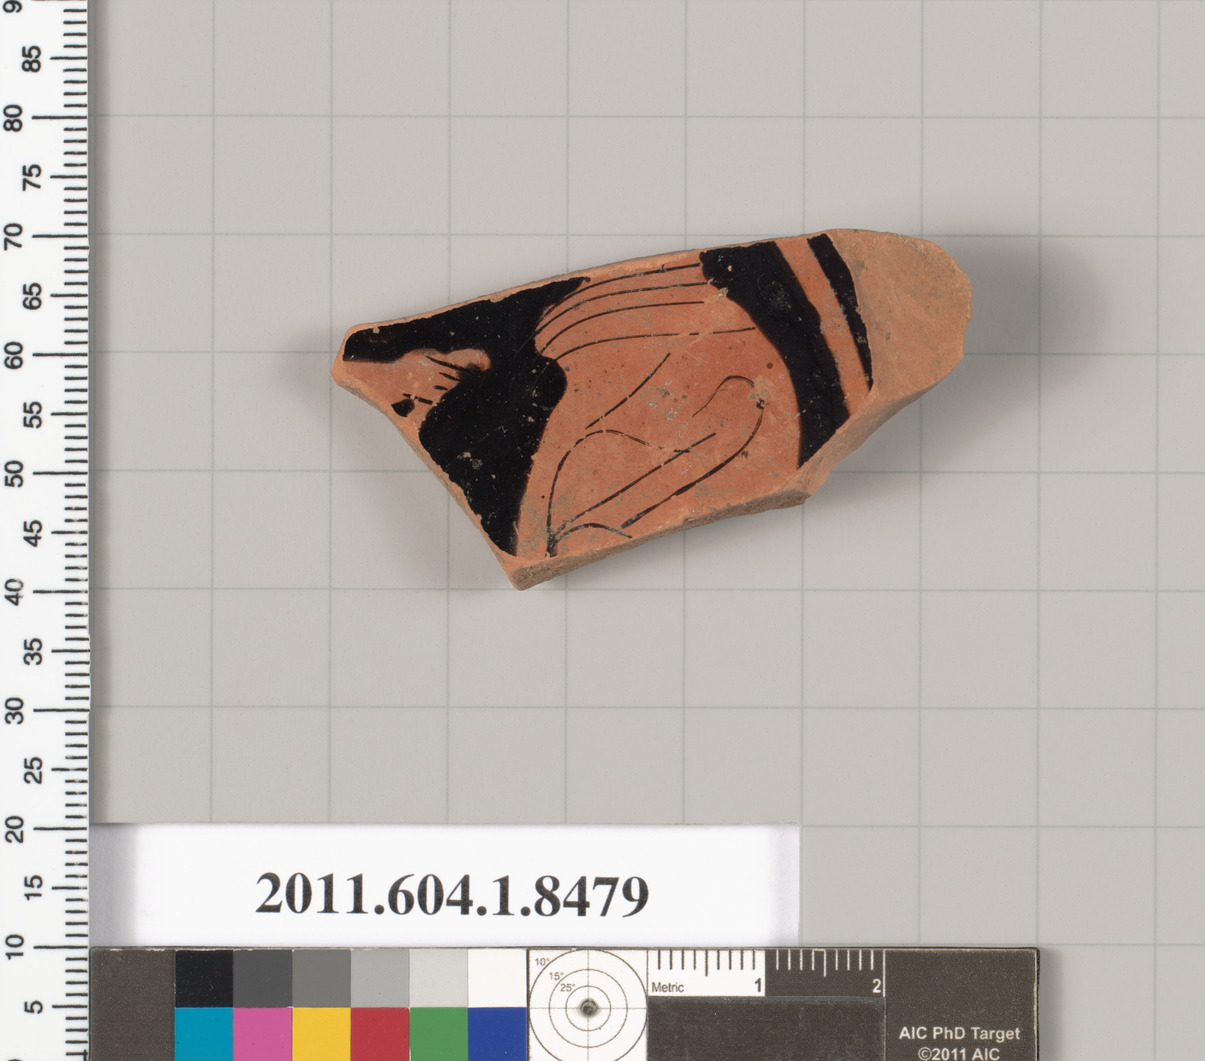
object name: kylix fragment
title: Terracotta fragment of a stemless kylix (drinking cup)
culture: greek, attic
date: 460-450 BCE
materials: terracotta